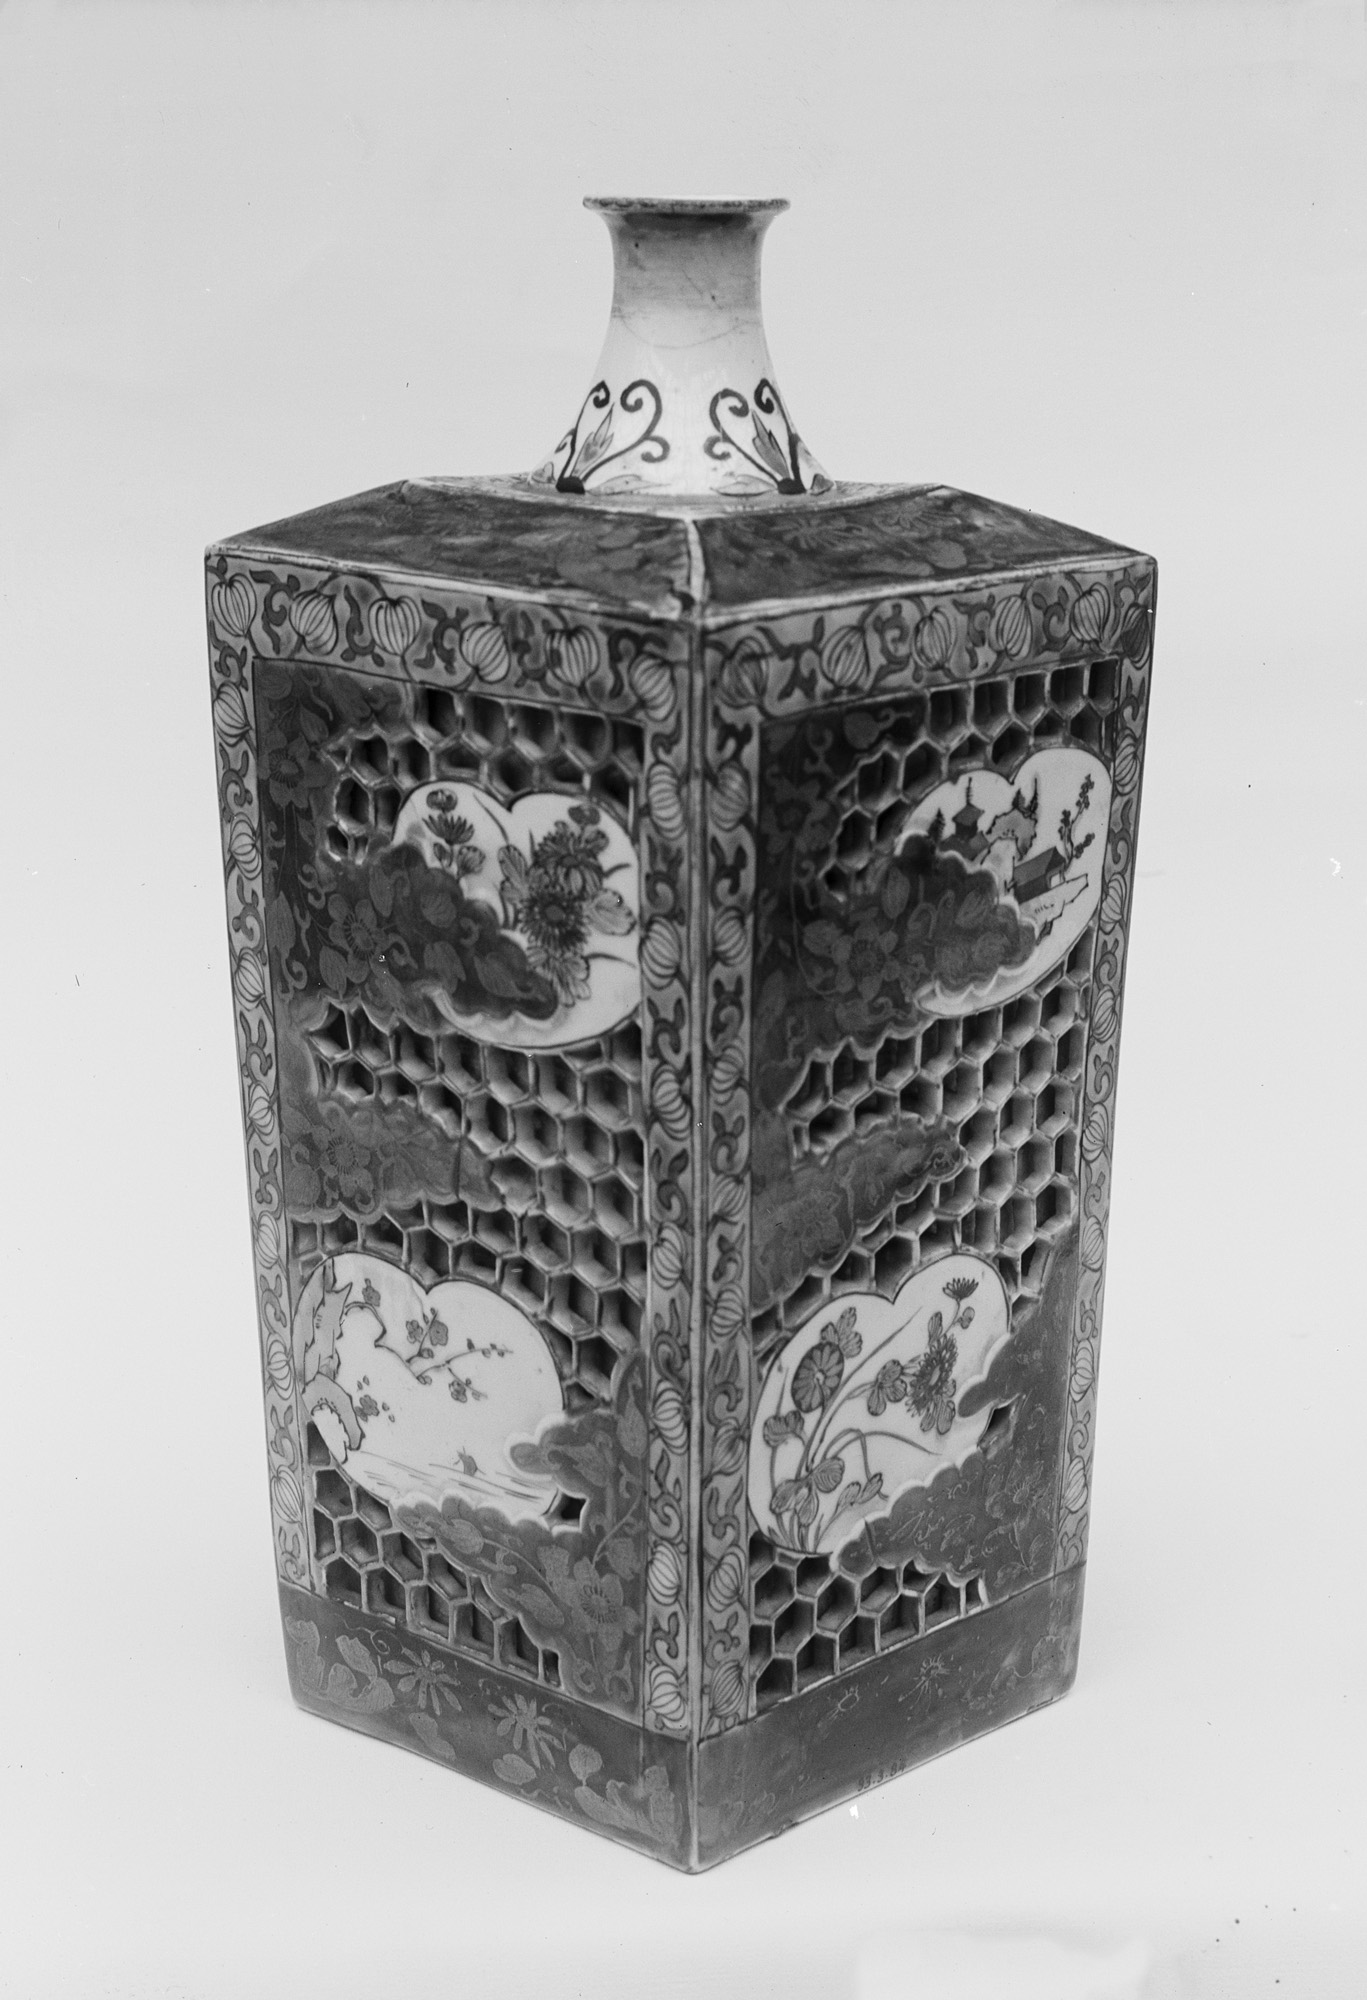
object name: bottle, square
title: Square Bottle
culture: japanese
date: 1701-1733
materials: enamel, glaze, porcelain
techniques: polychrome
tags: flowers